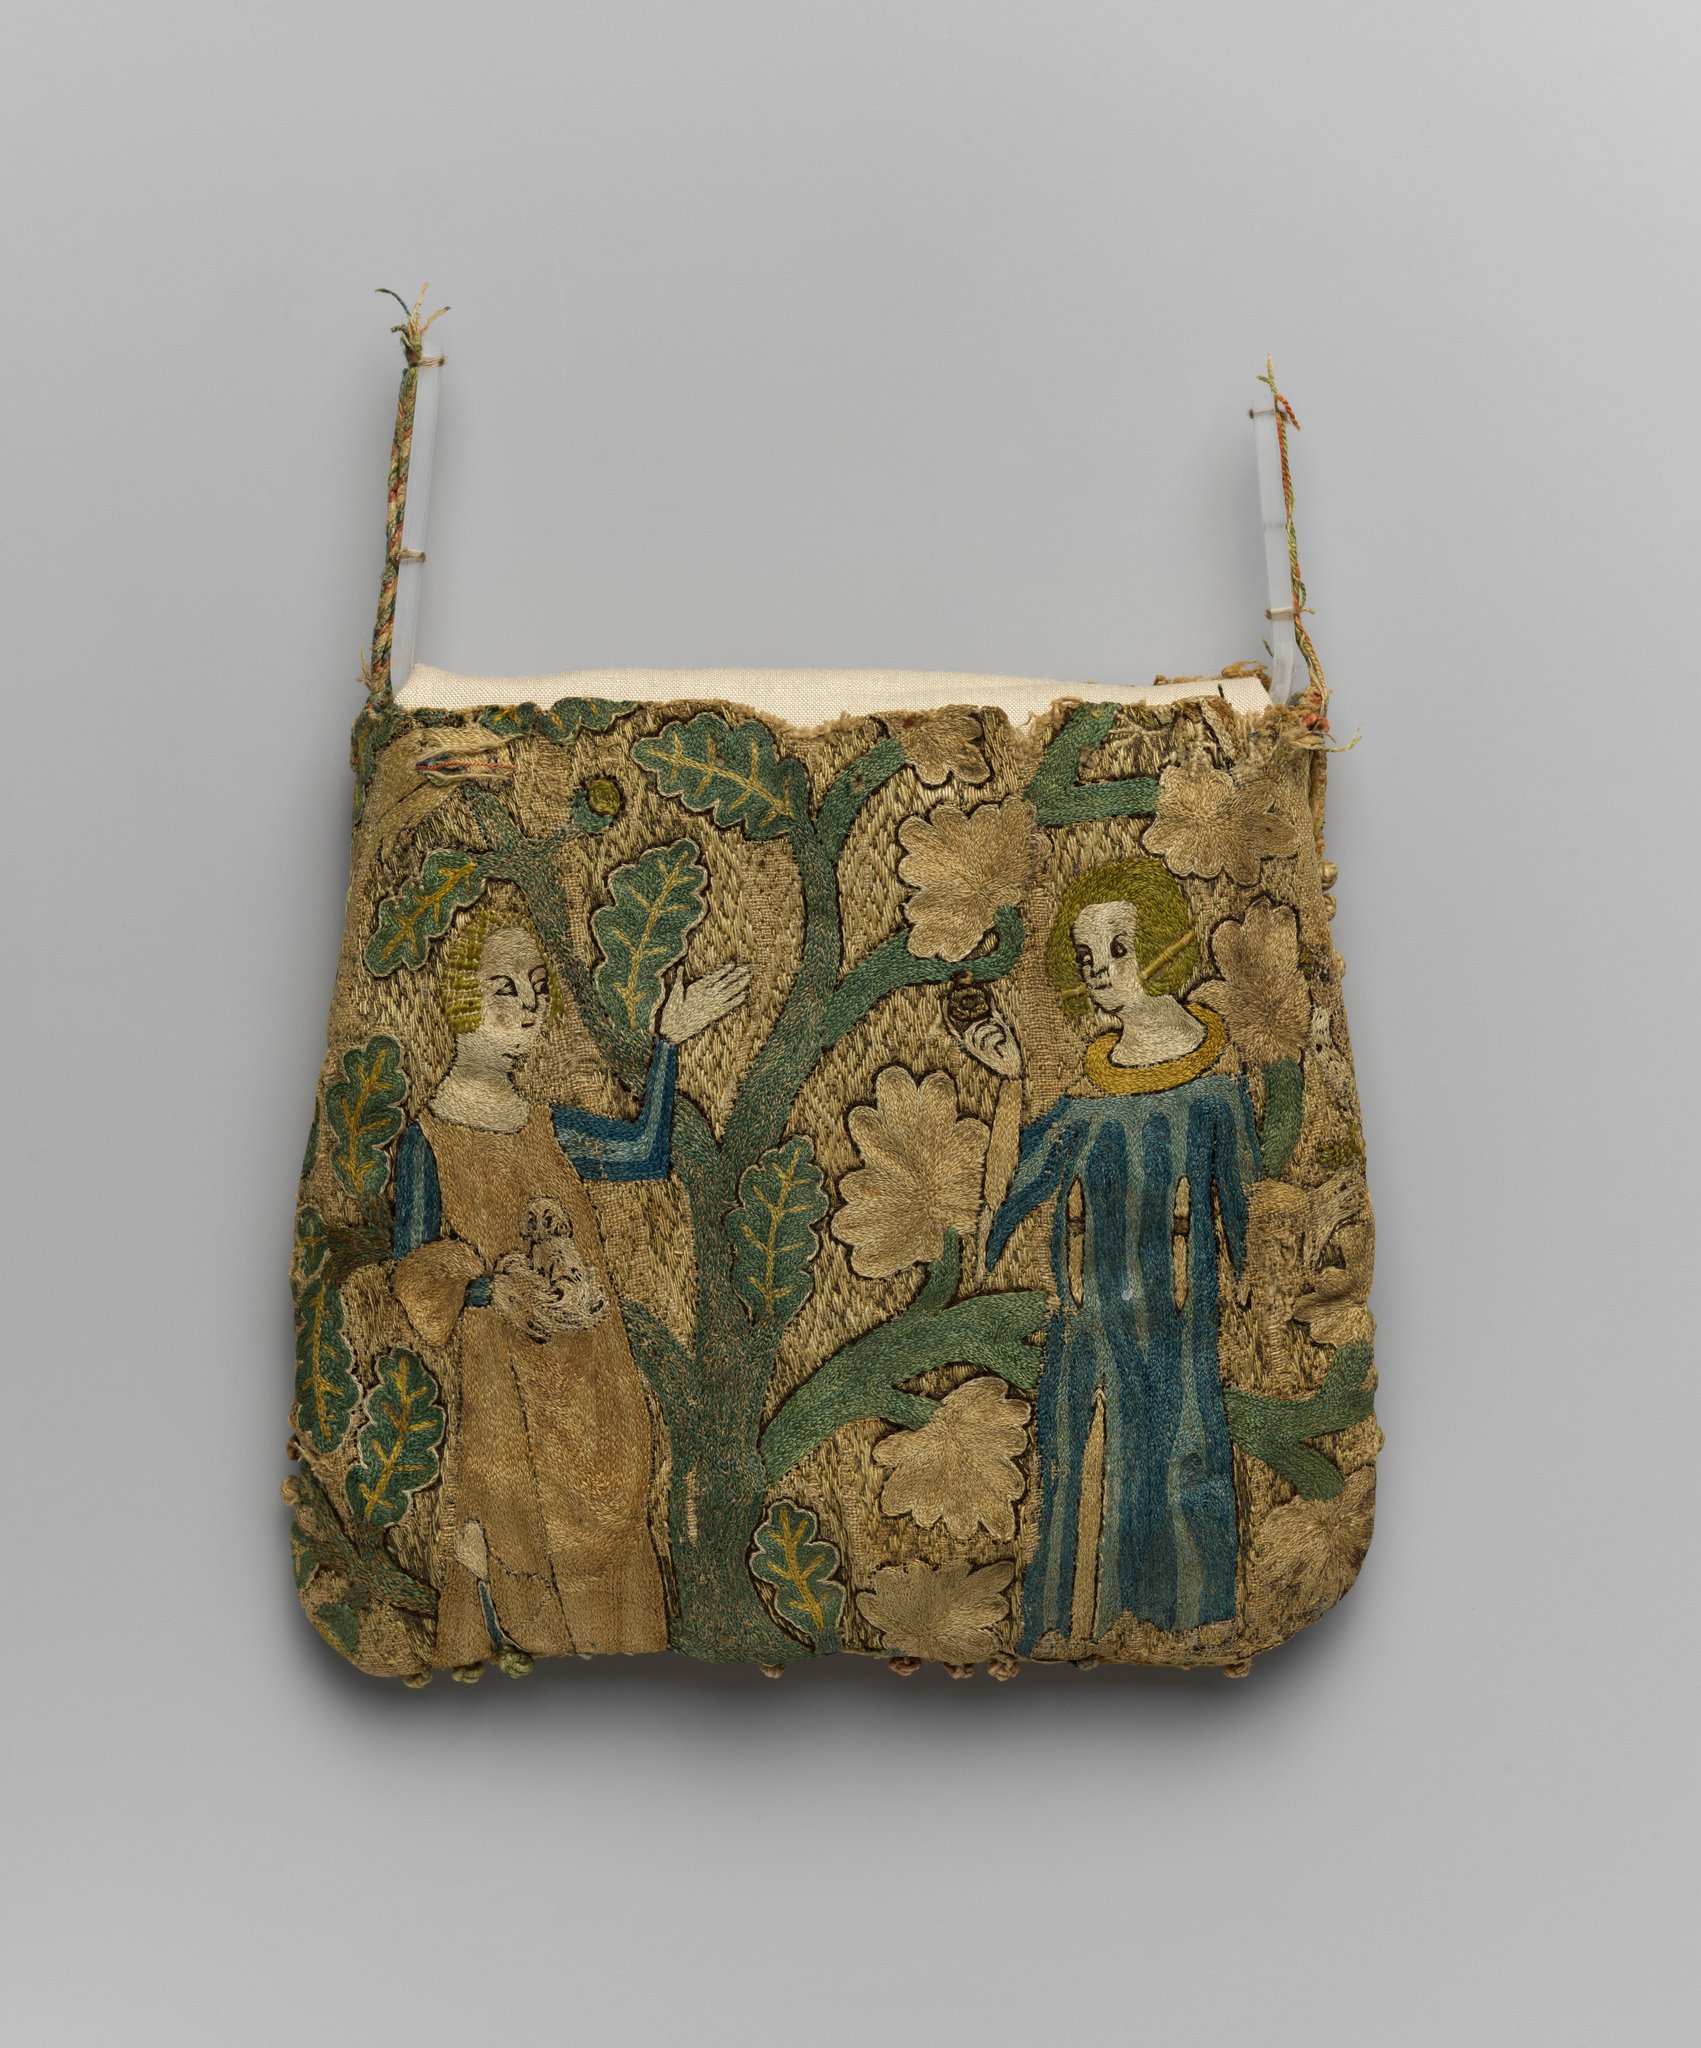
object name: purse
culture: french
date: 1301-1333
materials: gold leaf, linen, silk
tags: men,women,dogs,trees